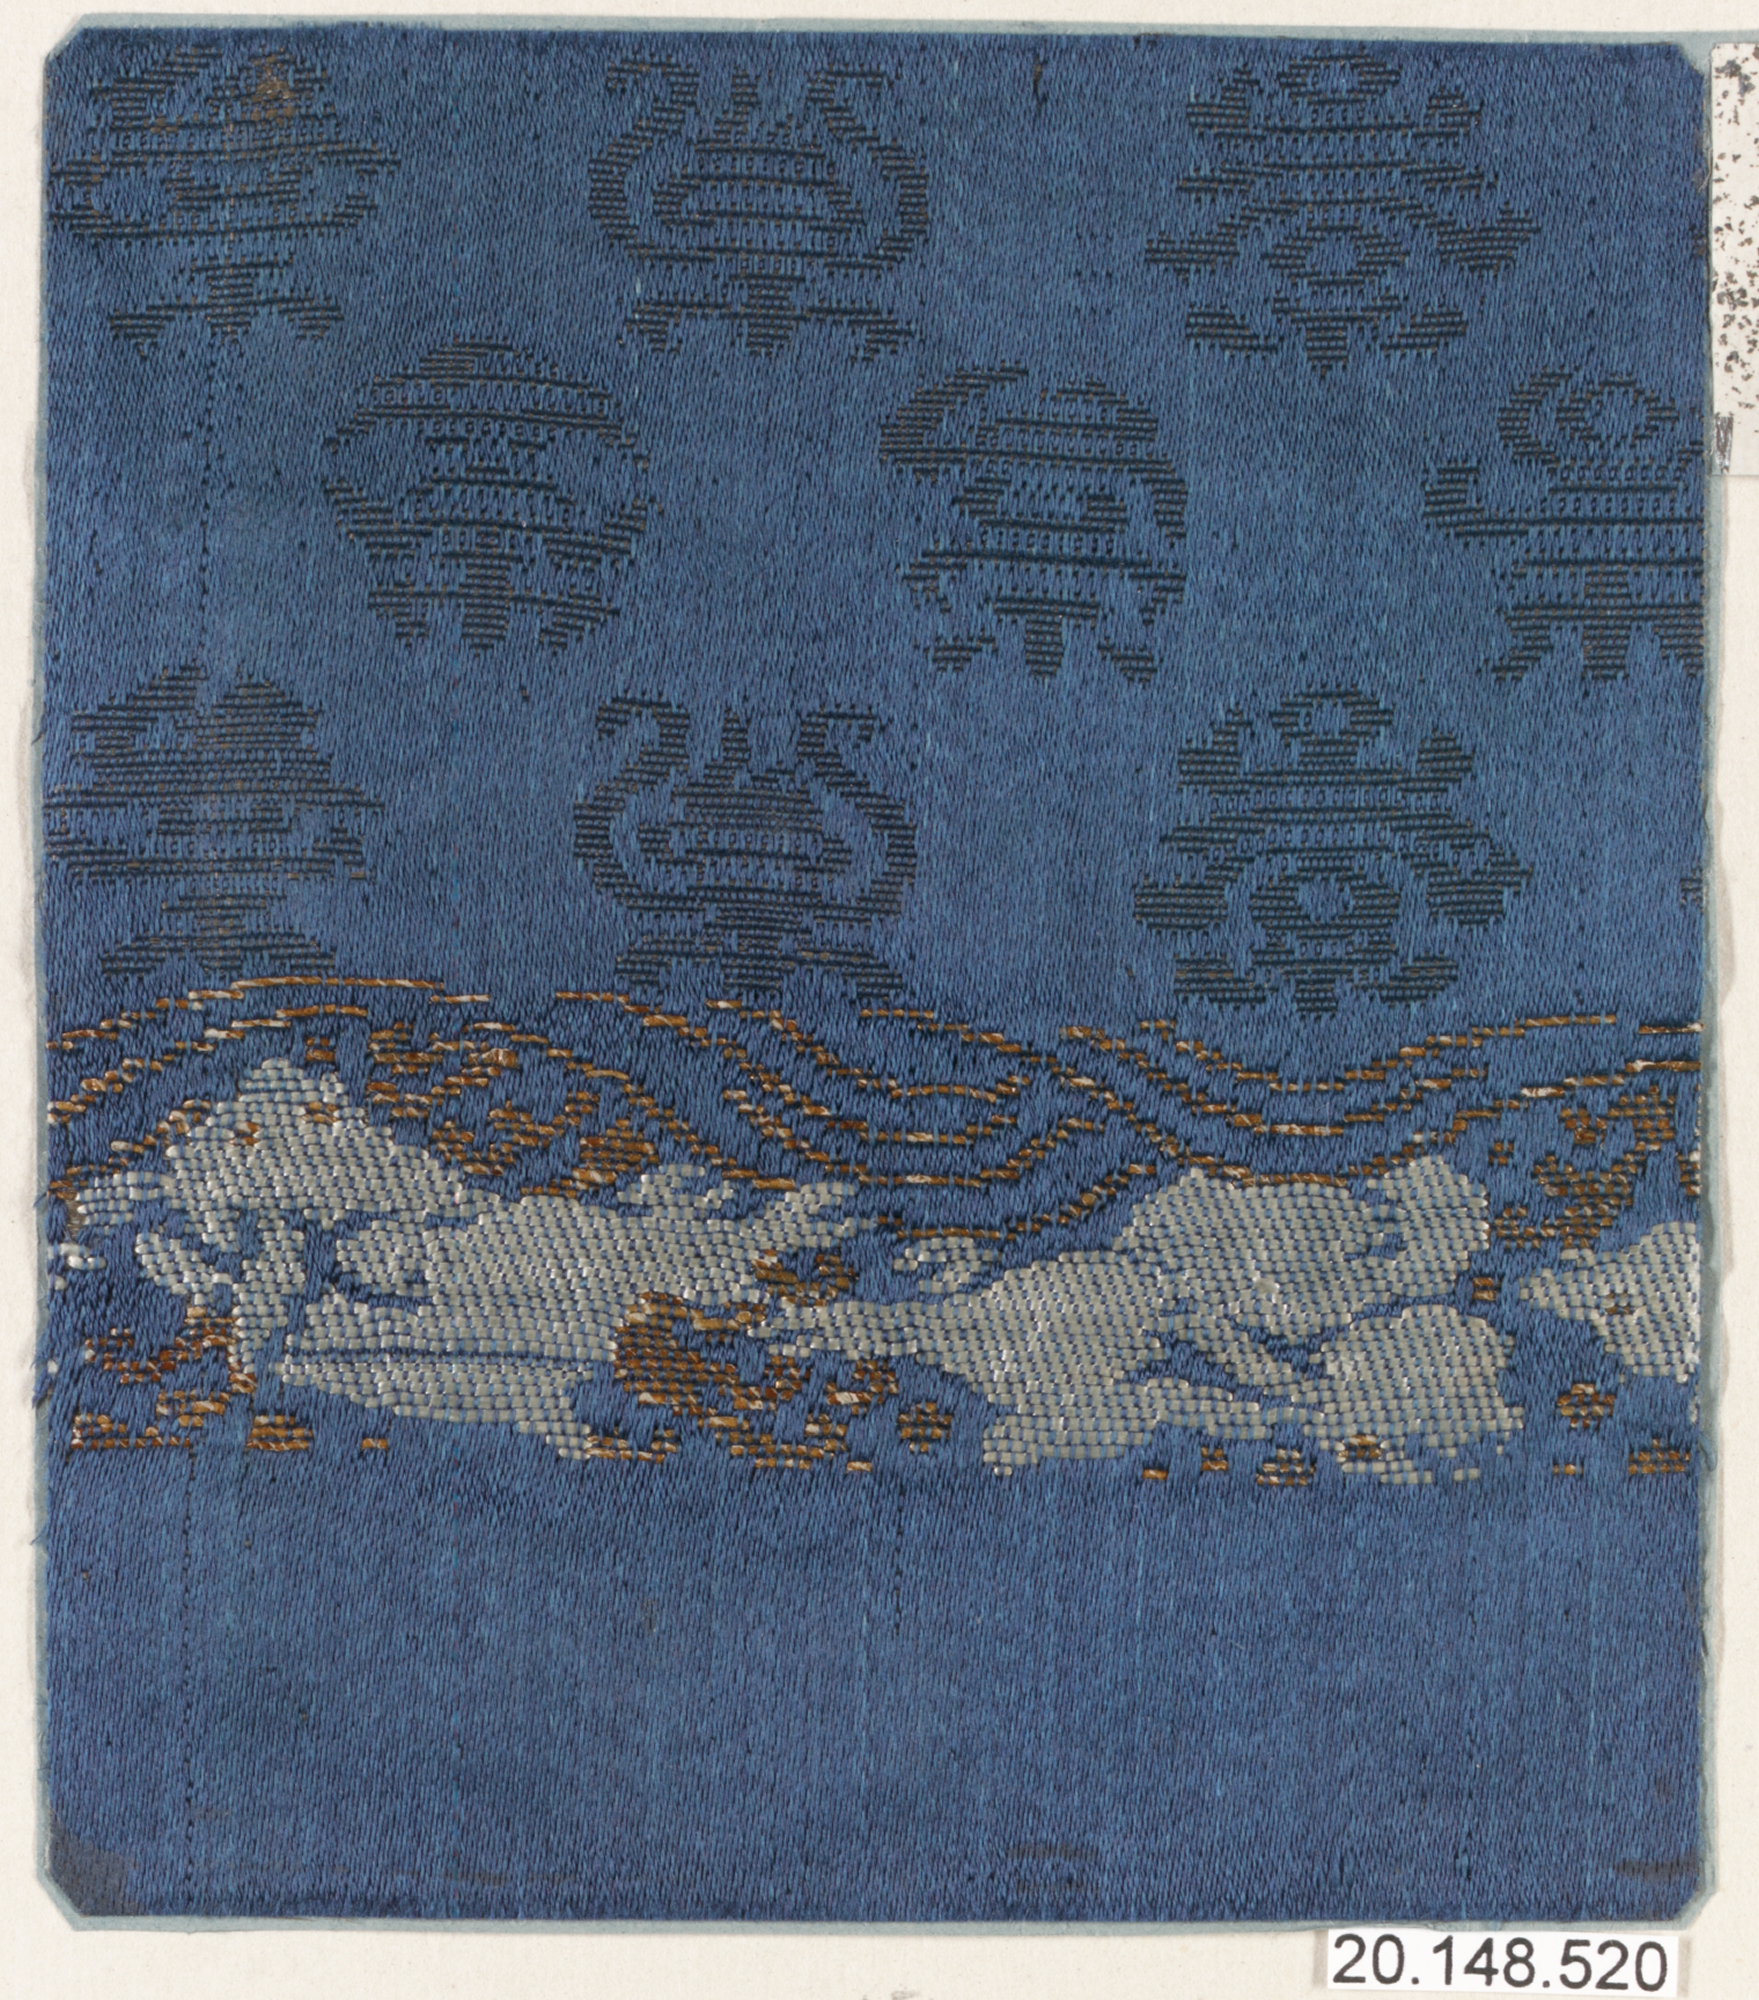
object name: piece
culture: japanese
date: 1701-1800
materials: silk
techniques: compound weave